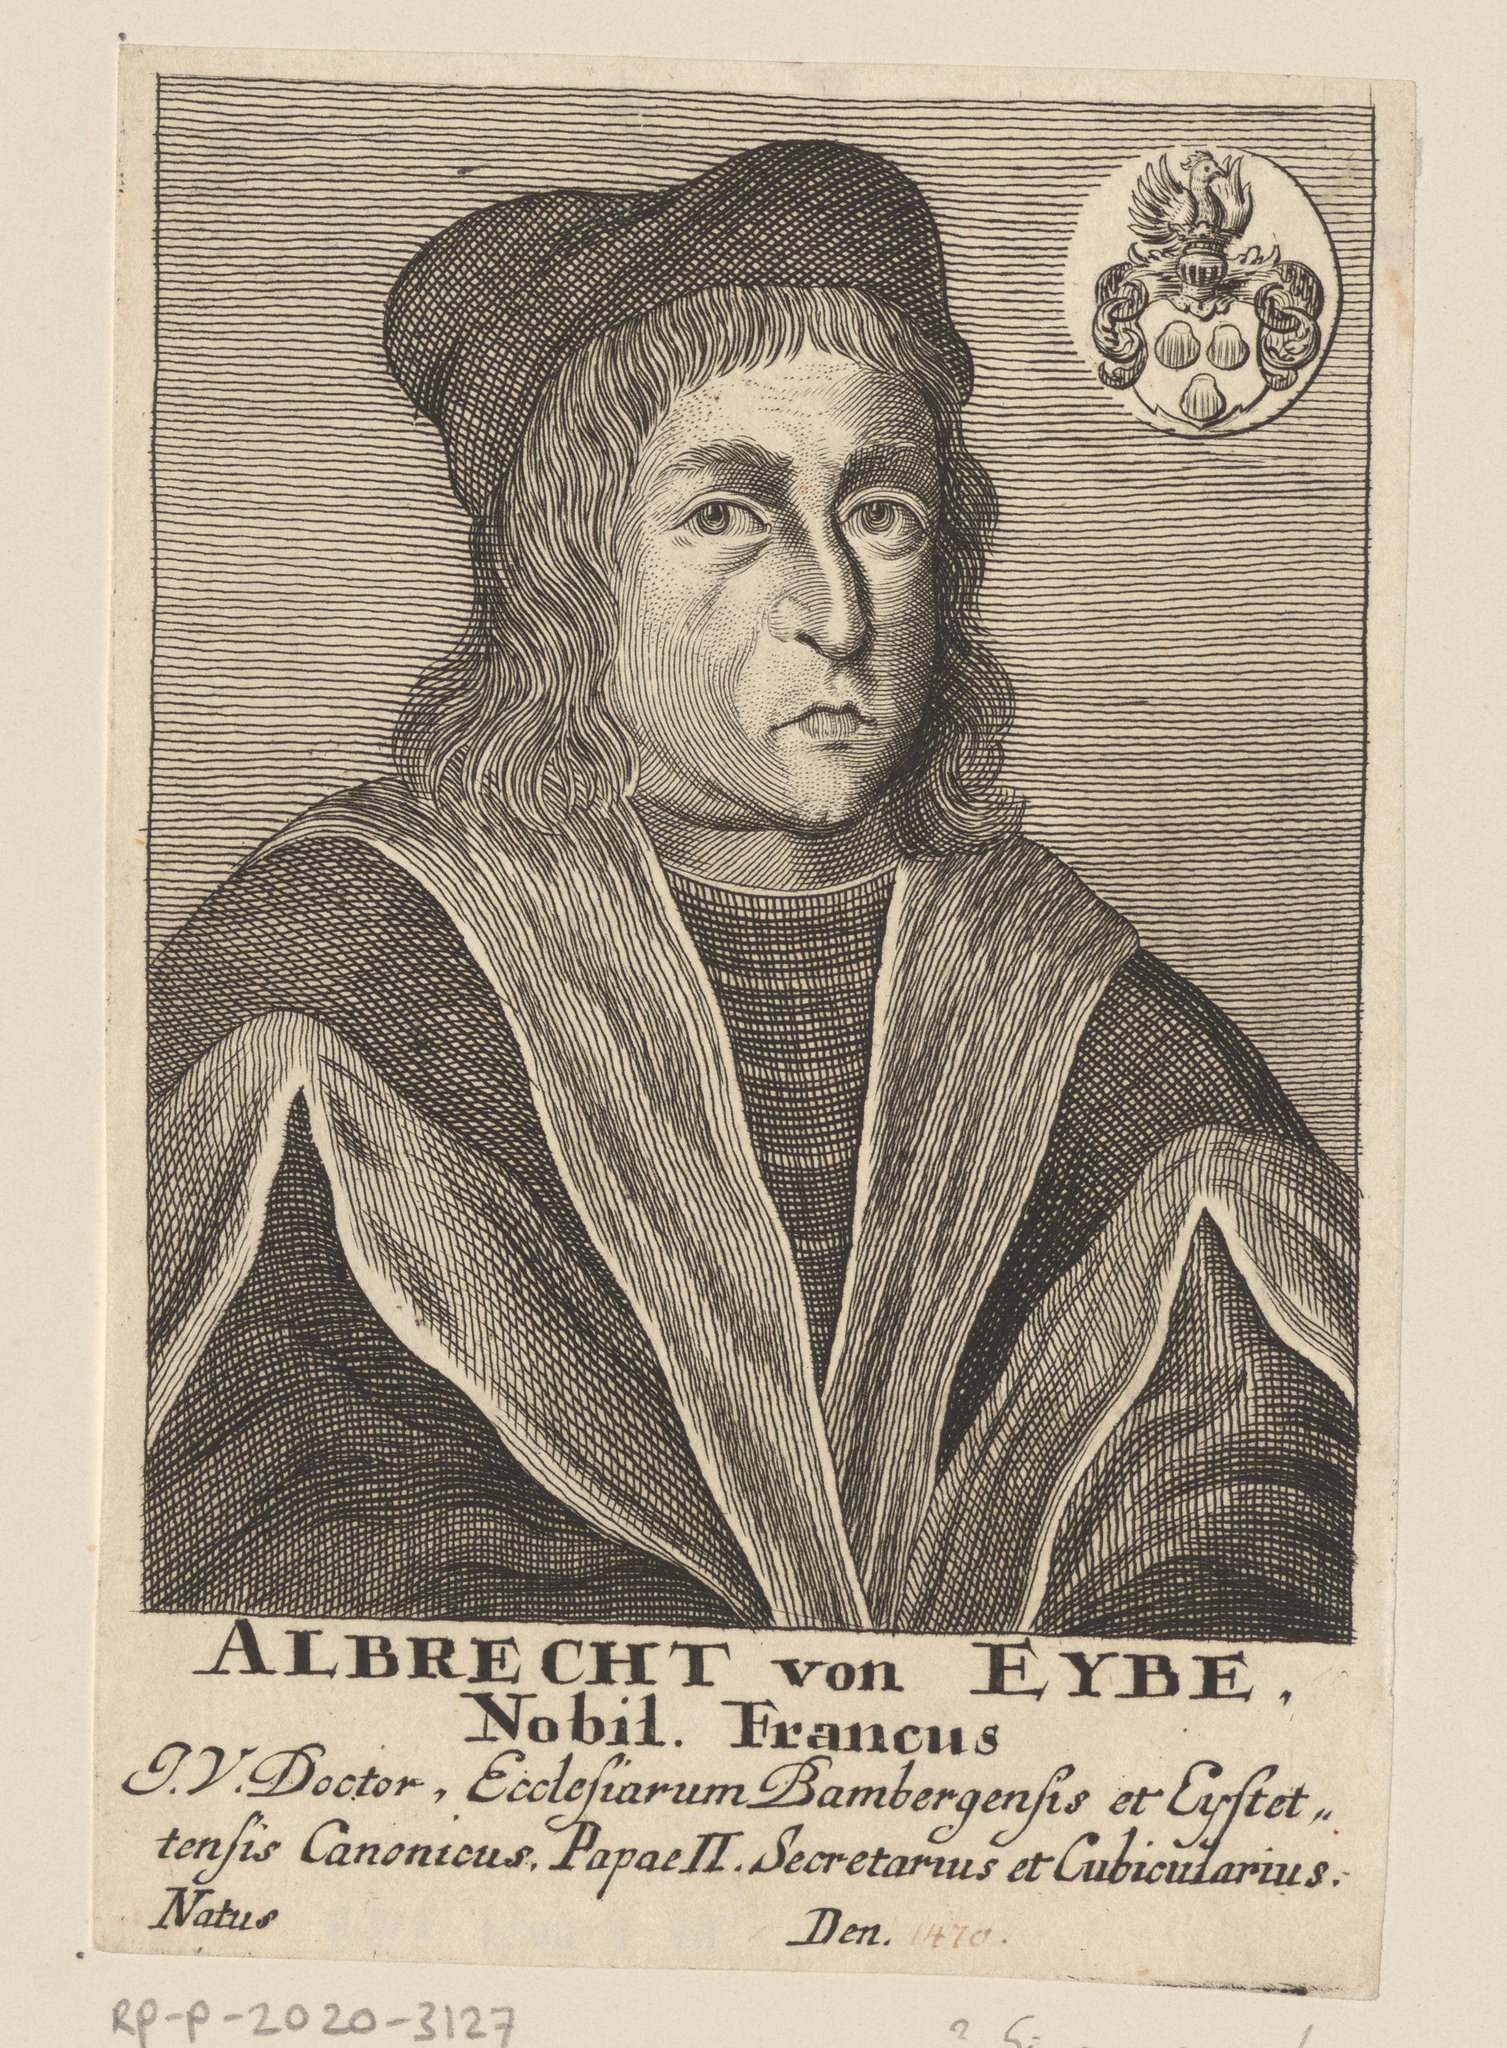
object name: book illustration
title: Portret van Albrecht von Eyb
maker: Anonymous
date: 1725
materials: paper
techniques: engraving, etching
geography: nuremberg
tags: historical persons, scholar, philosopher (+ portrait of scholar, scientist), armorial bearing, heraldry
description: Prent waarschijnlijk uit: Roth-Scholtz, Friedrich. Icones virorum omnium ordinum eruditione omnique item genere (...). Neurenberg: erven Johann Daniel Tauber, 1725.